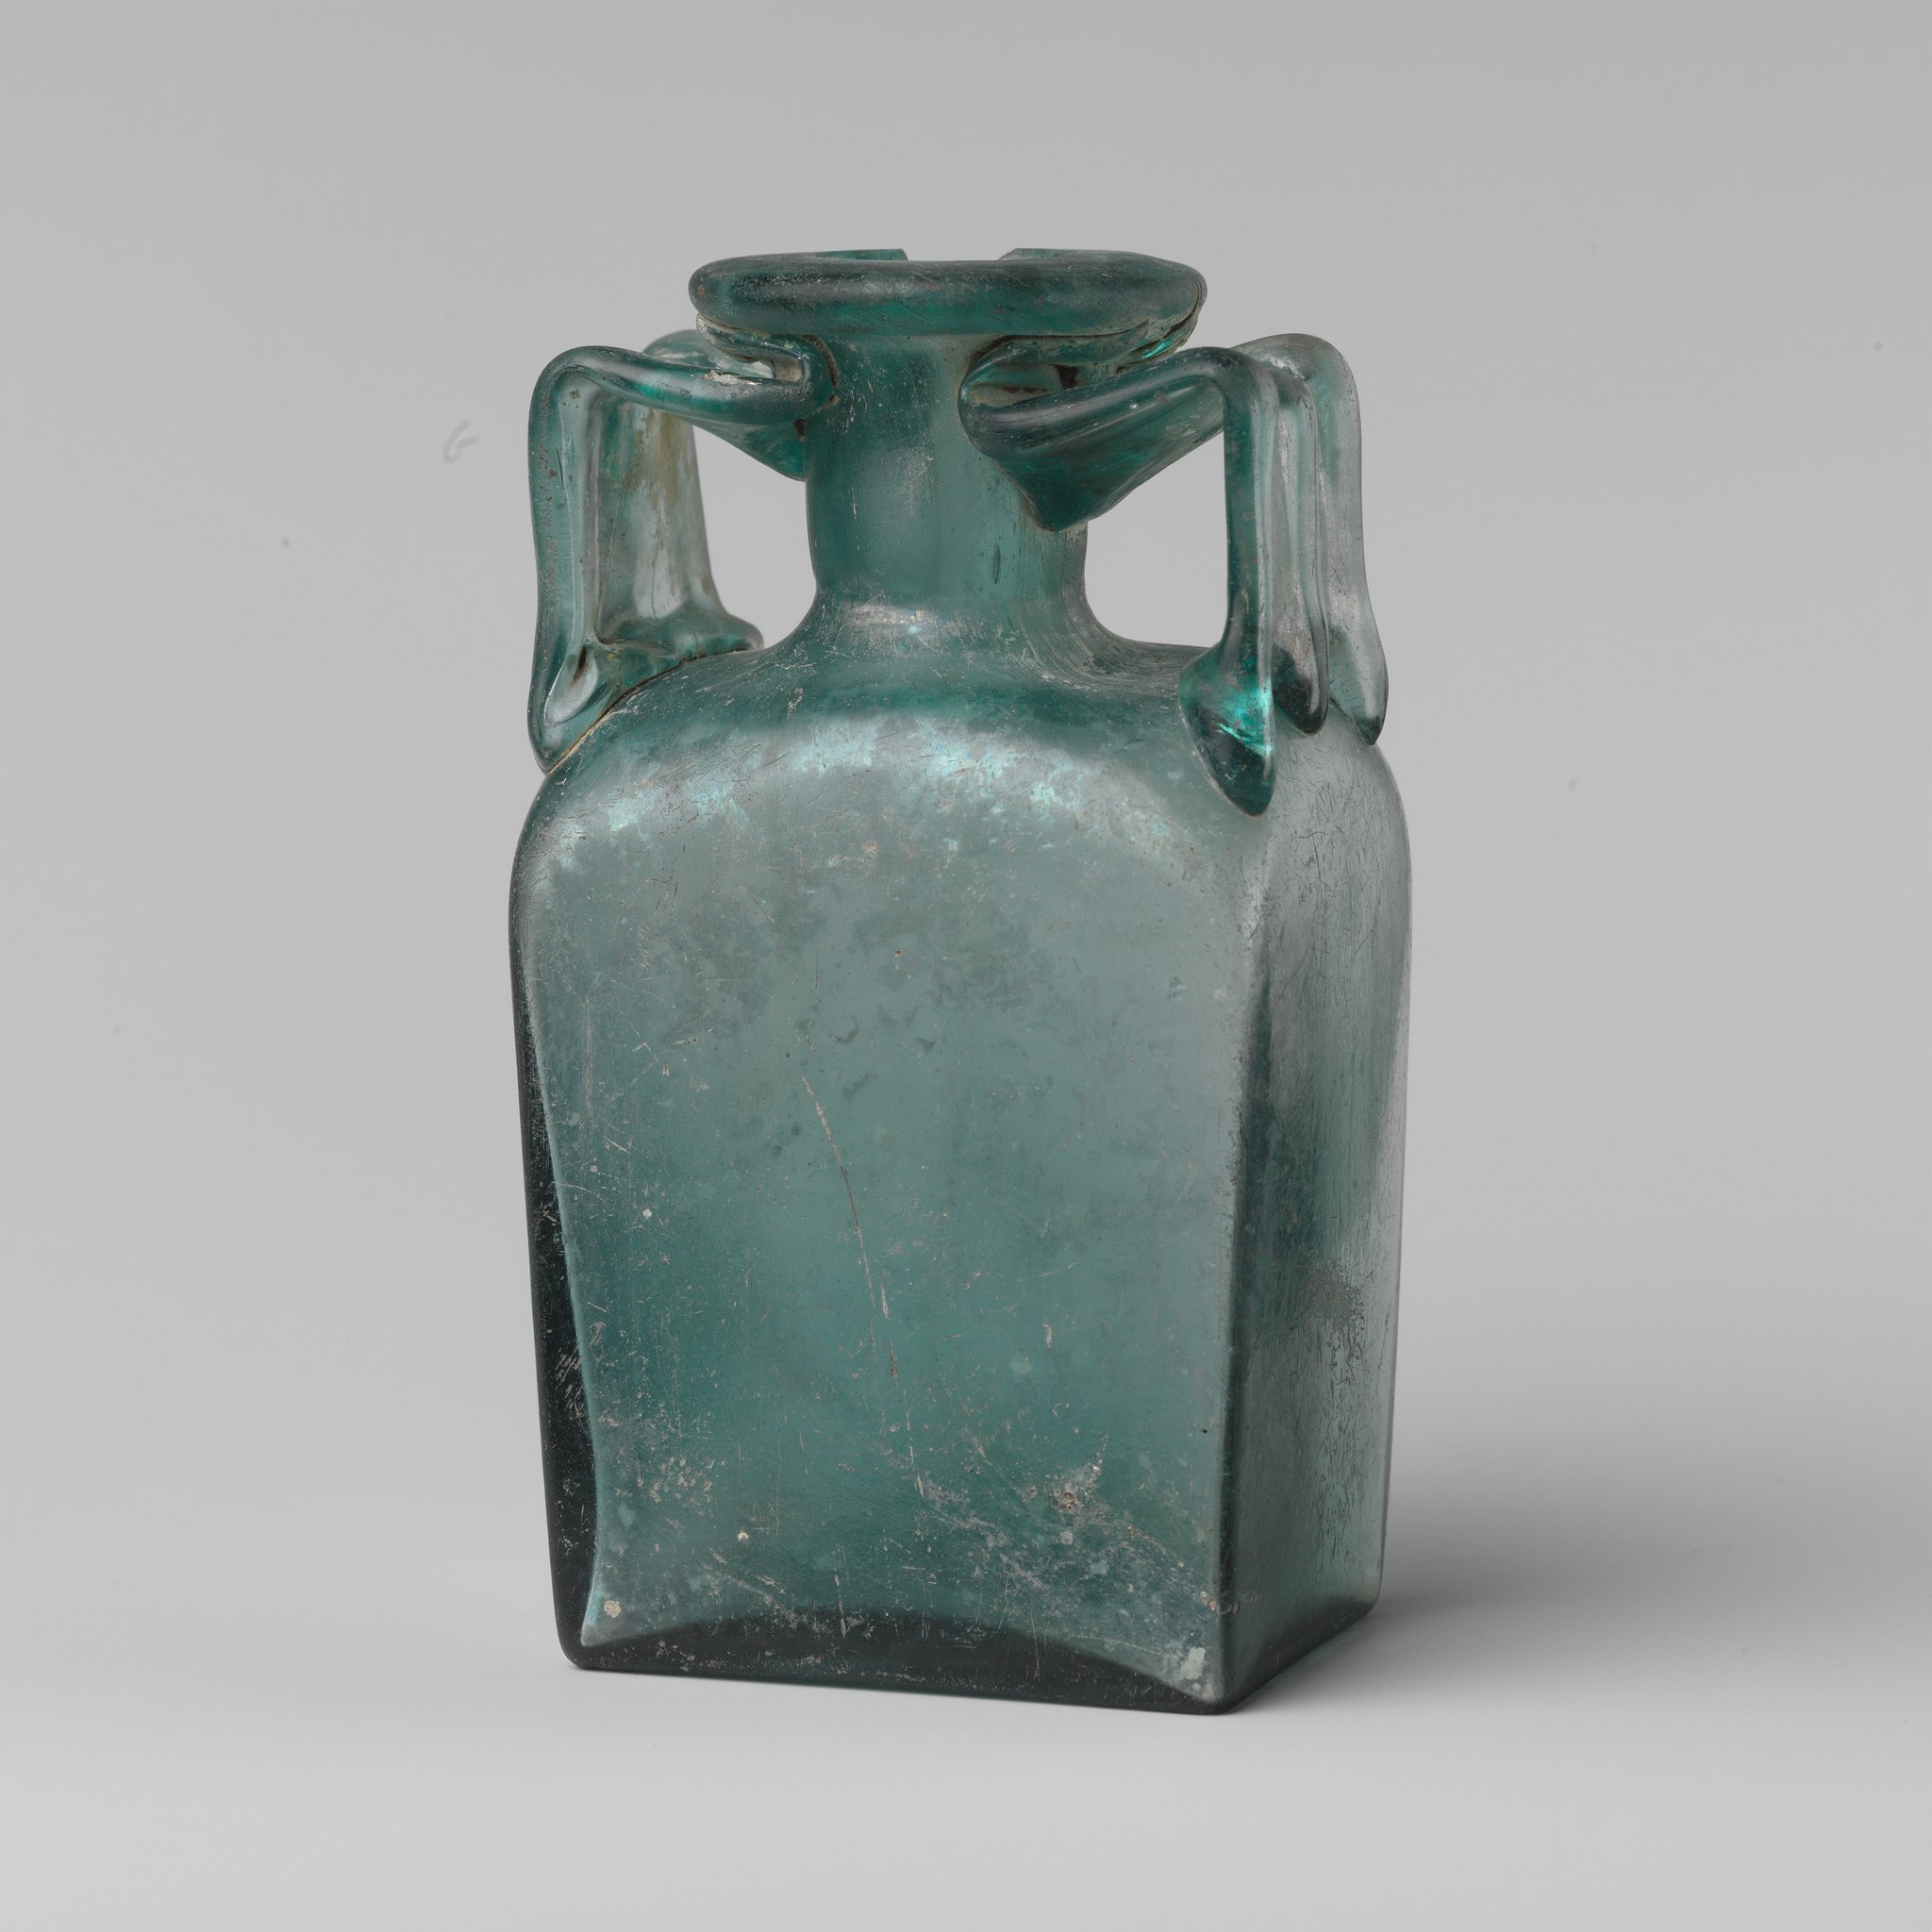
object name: bottle, rectangular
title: Glass rectangular bottle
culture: roman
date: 101-200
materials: glass